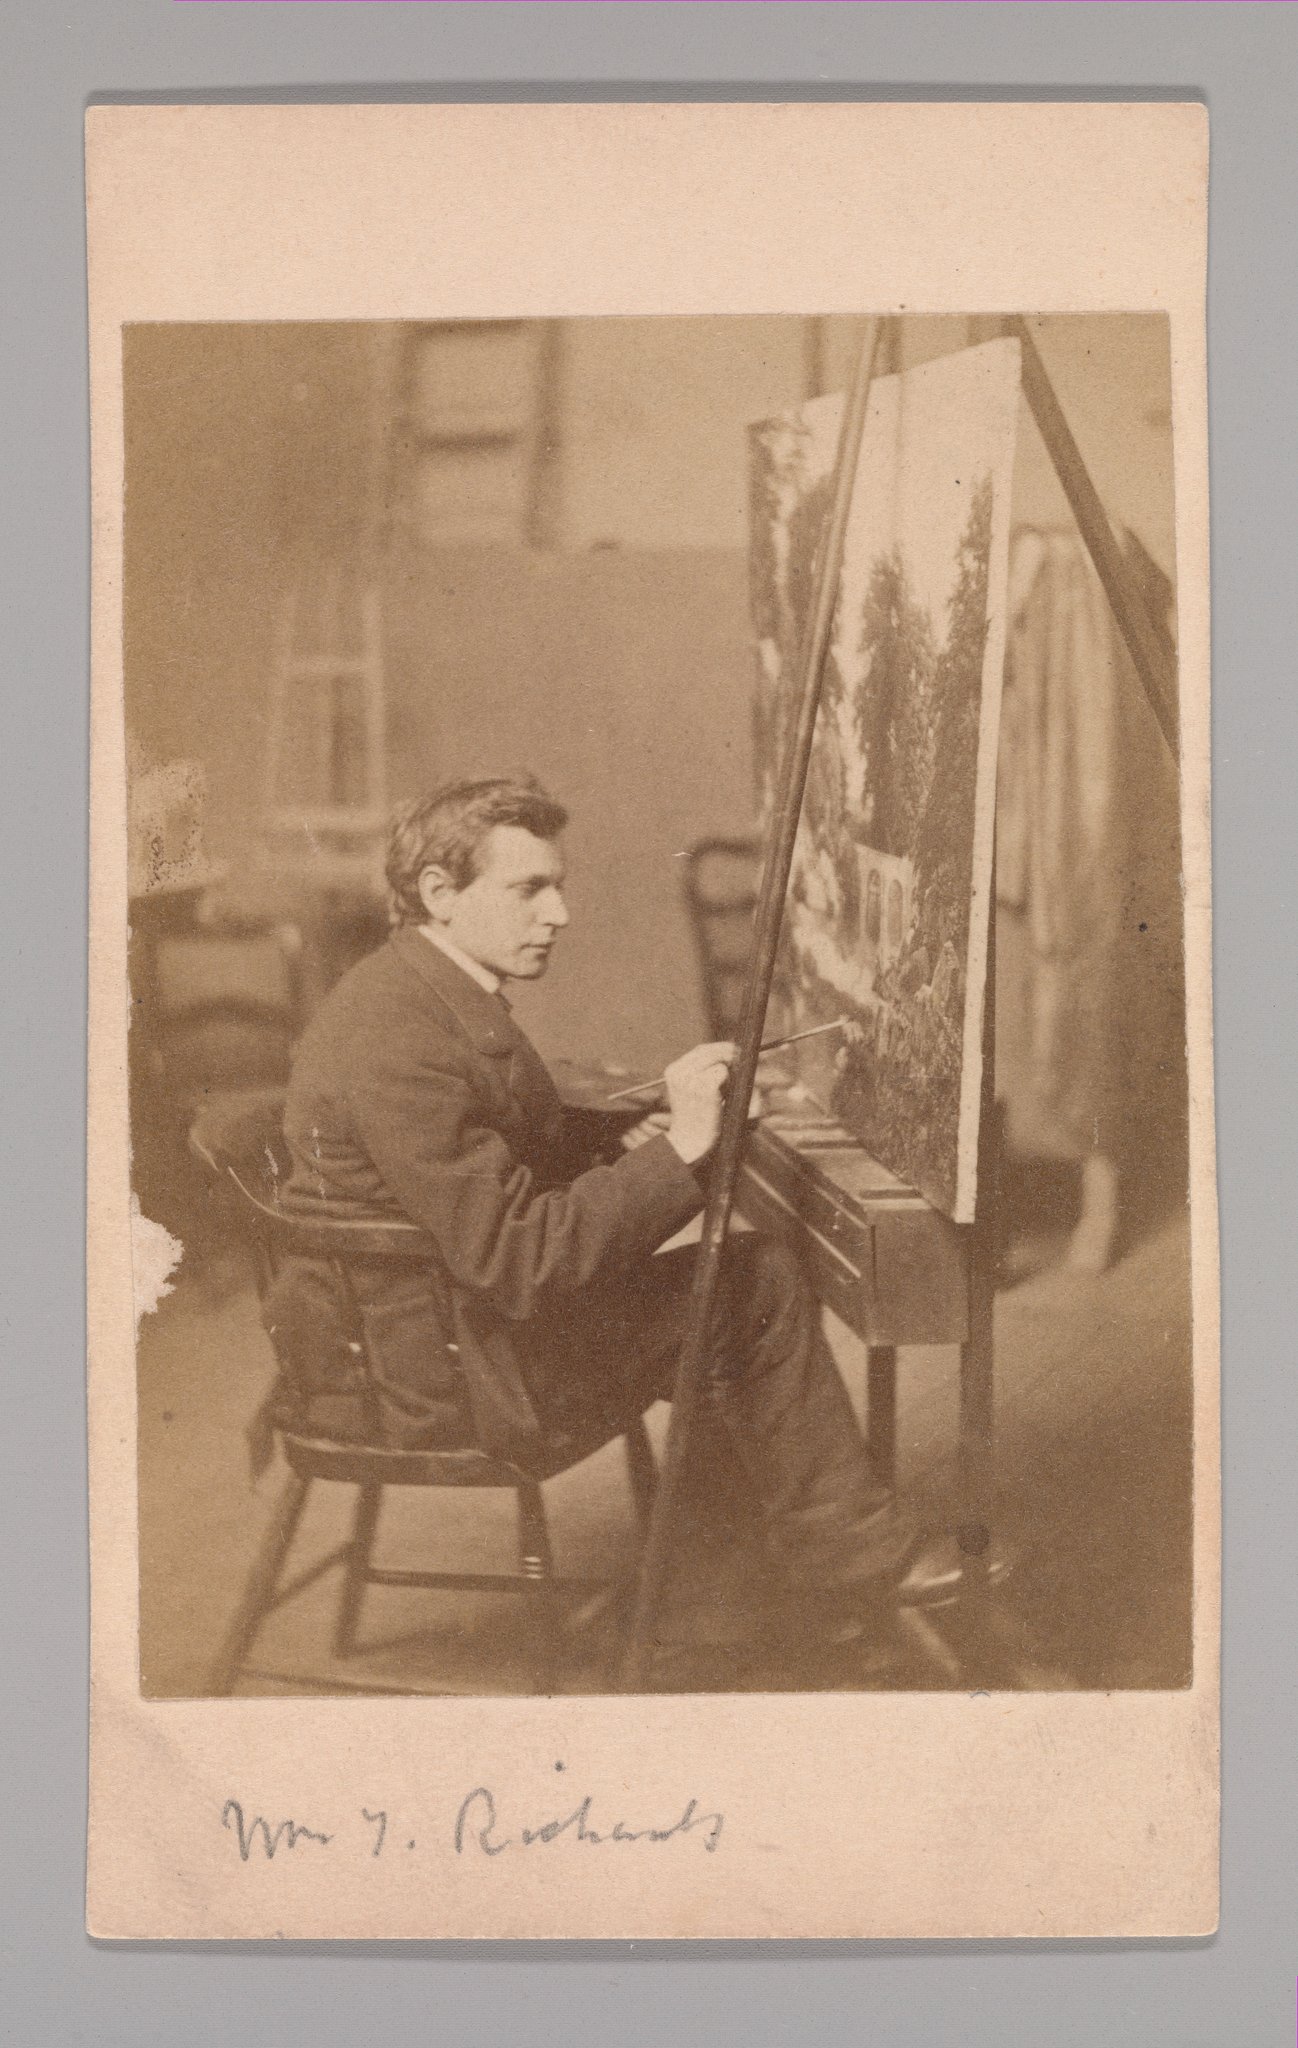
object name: carte de visite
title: [J. Richards ?]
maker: Anonymous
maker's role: artist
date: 1860-1869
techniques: albumen silver print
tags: painting,men,profiles